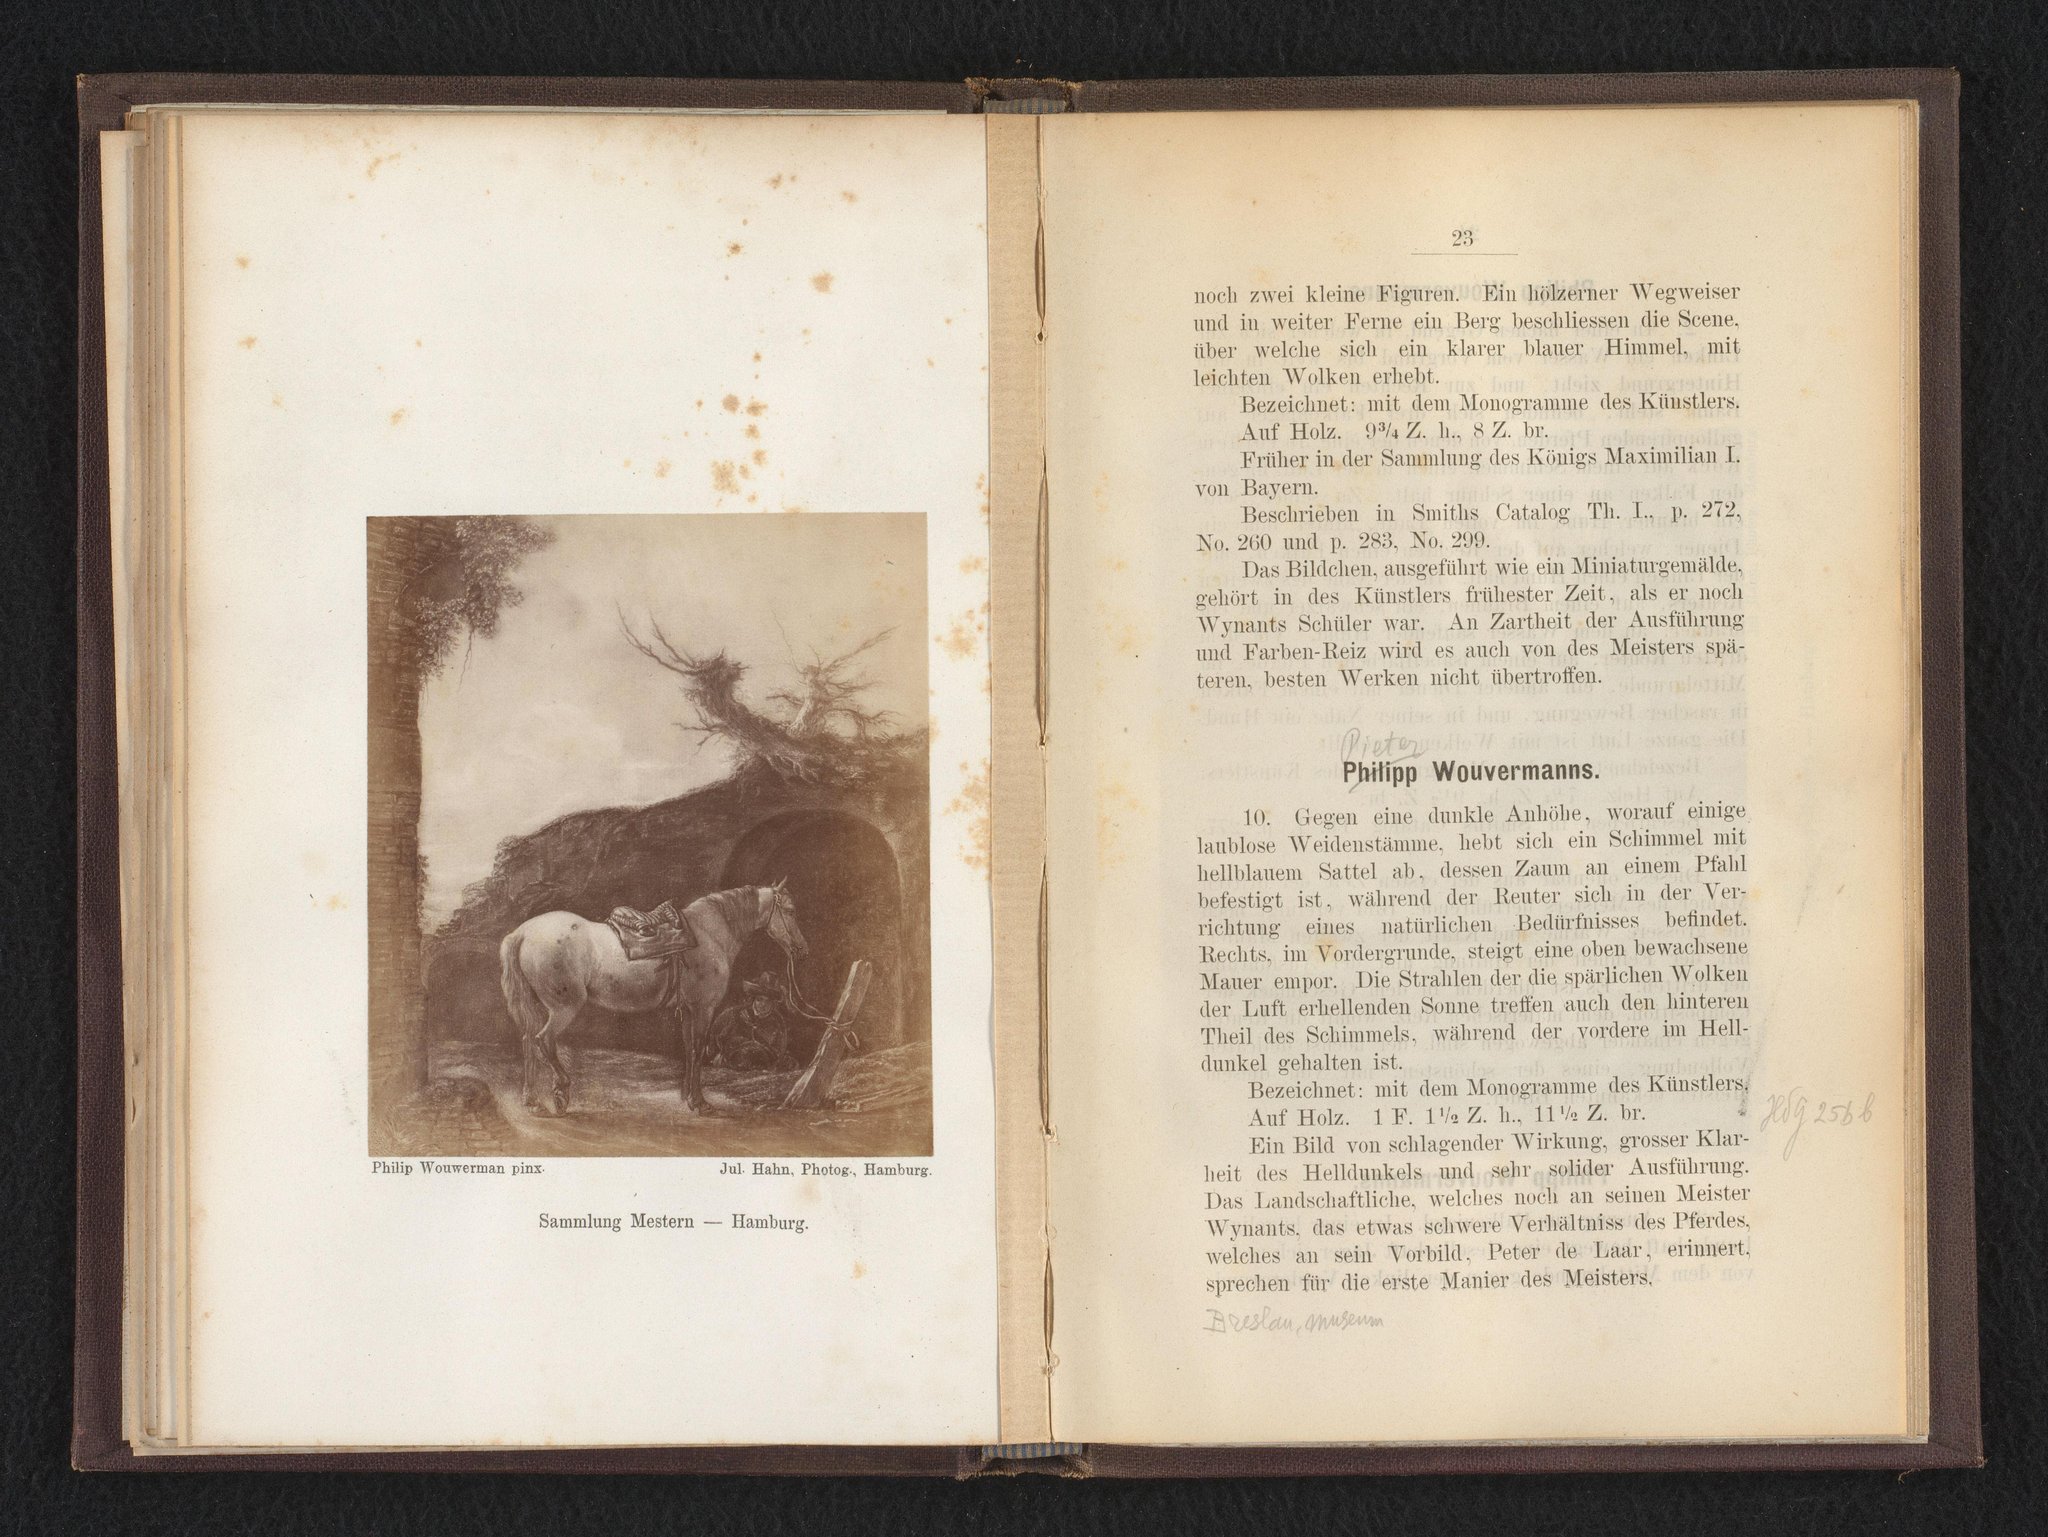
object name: reproduction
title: Fotoreproductie van een schilderij van een man rustend naast zijn paard door Philips Wouwerman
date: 1864-1874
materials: paper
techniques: albumen print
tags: horse, picture, painting